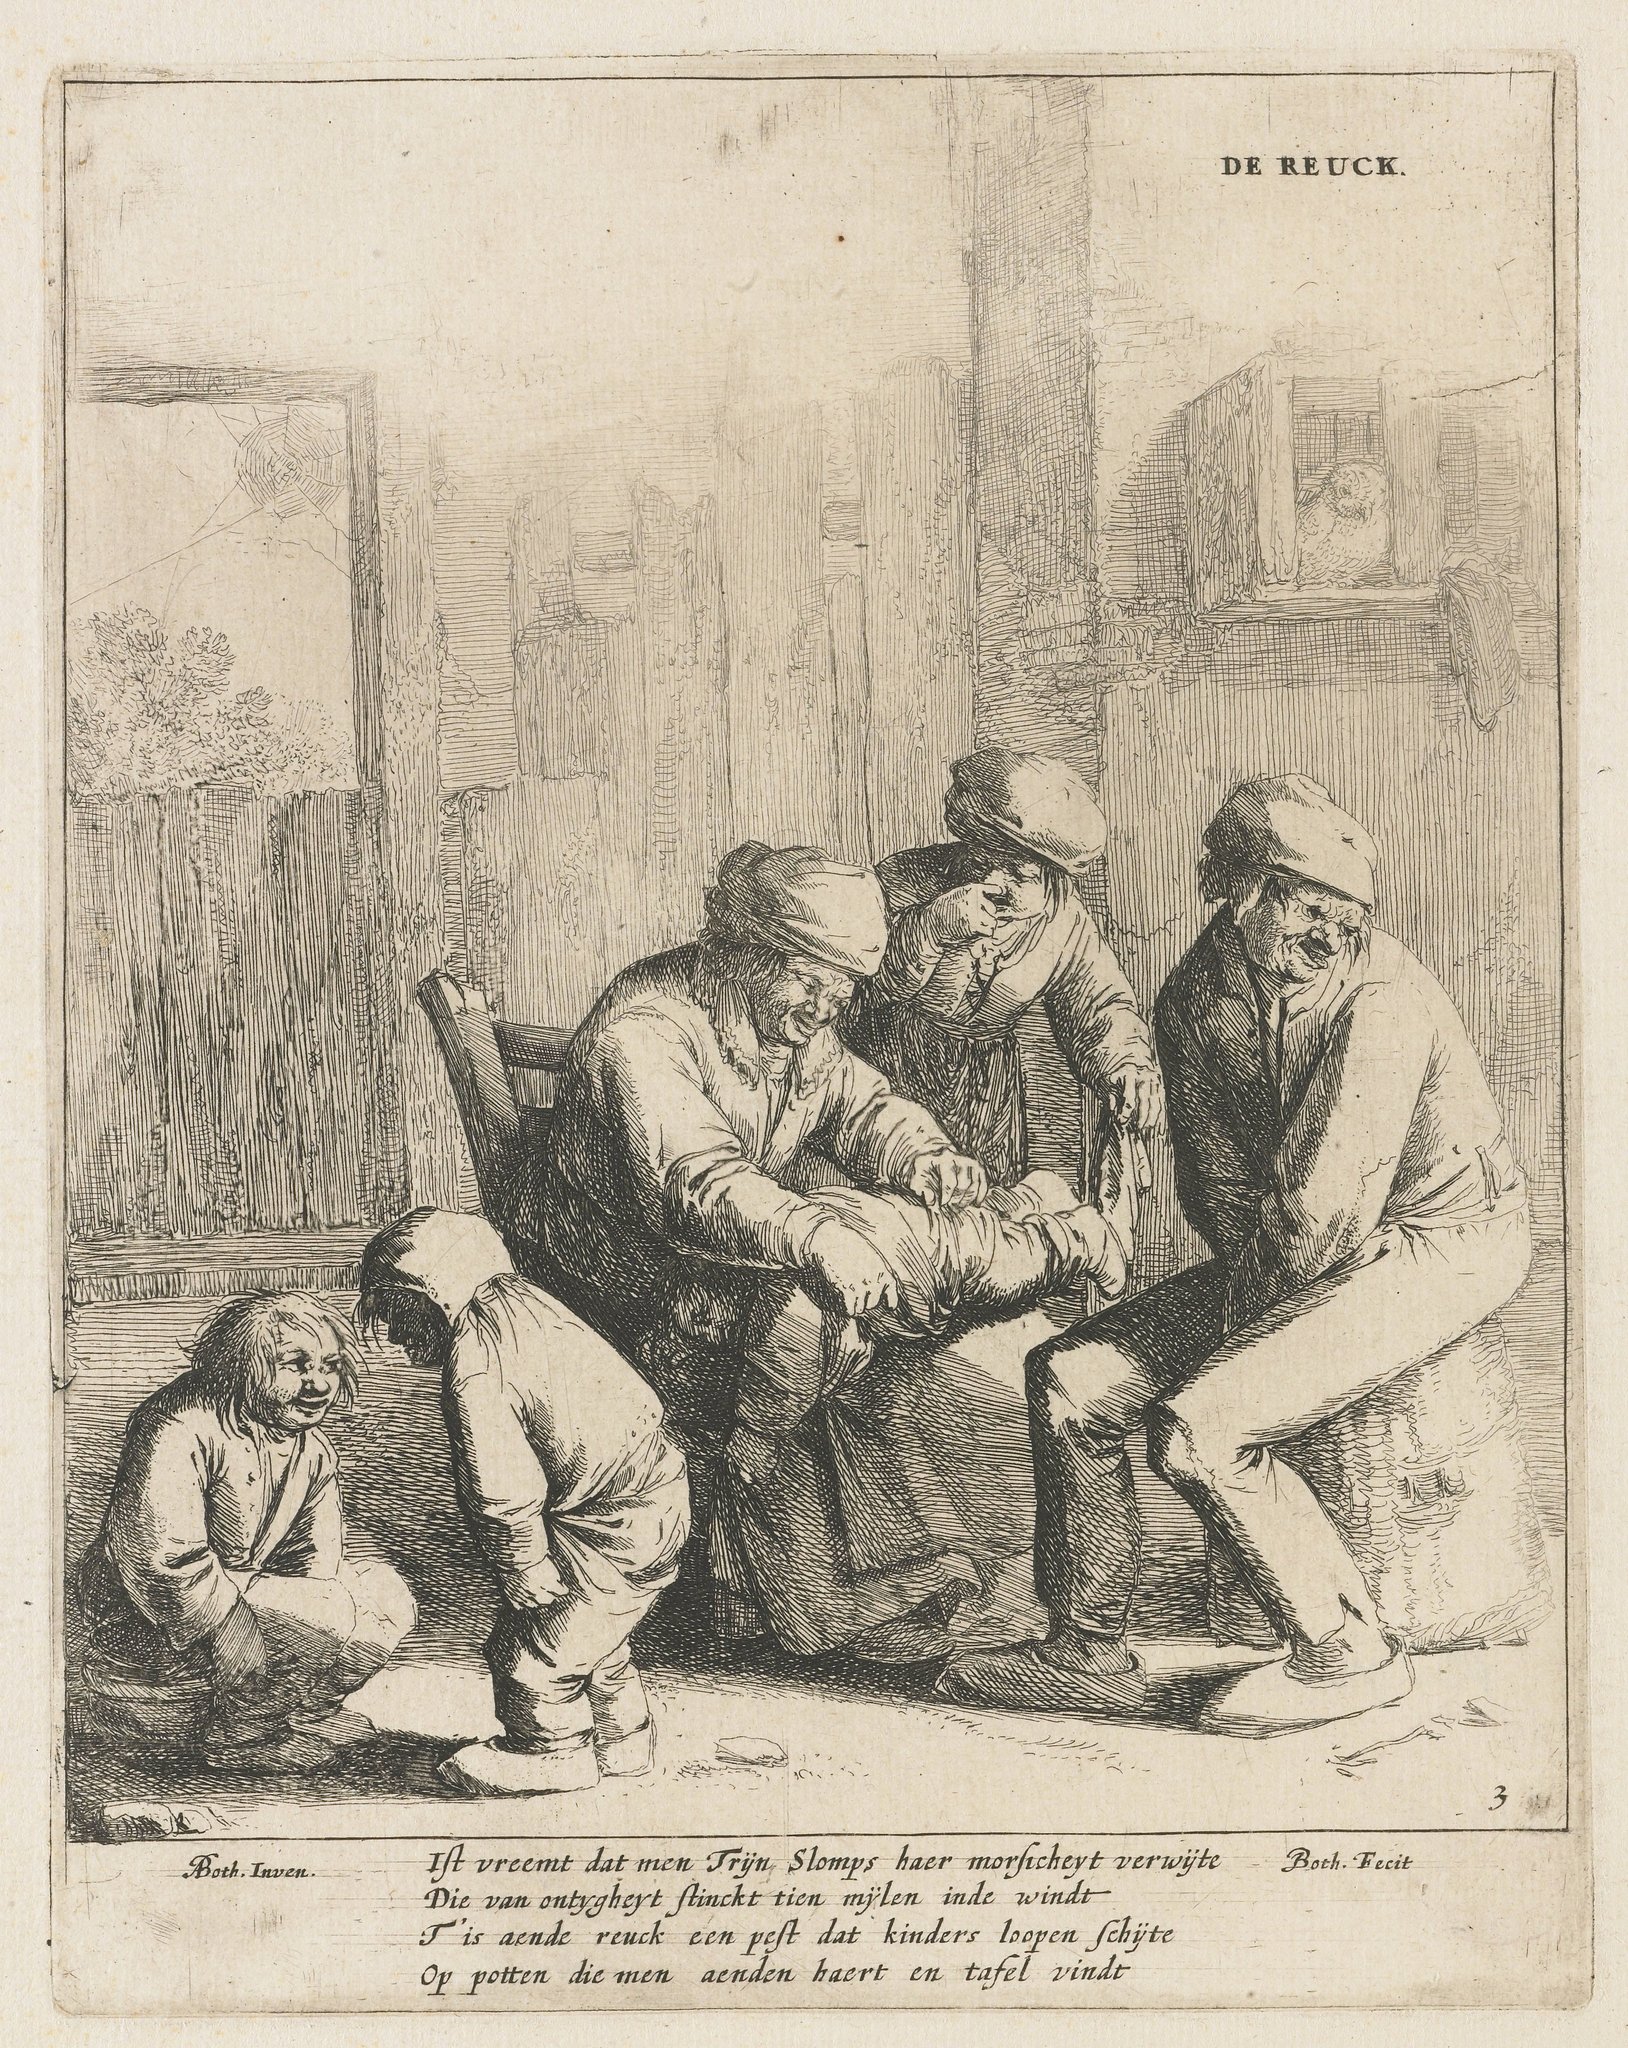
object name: print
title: De Reuck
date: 1620-1638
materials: paper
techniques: etching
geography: netherlands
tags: child, smell, smelling (one of the five senses), napkin (~ washing and changing baby)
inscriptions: collector's mark: Lugt 240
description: Het zintuig Reuk uitgebeeld met moeder die de luier van haar kind verschoont terwijl een man en vrouw hun neus ophalen en een kind op een pot zit welke ook wordt gebruikt om te koken. De tekst van vier regels onder de afbeelding drijft de spot met het zintuig.